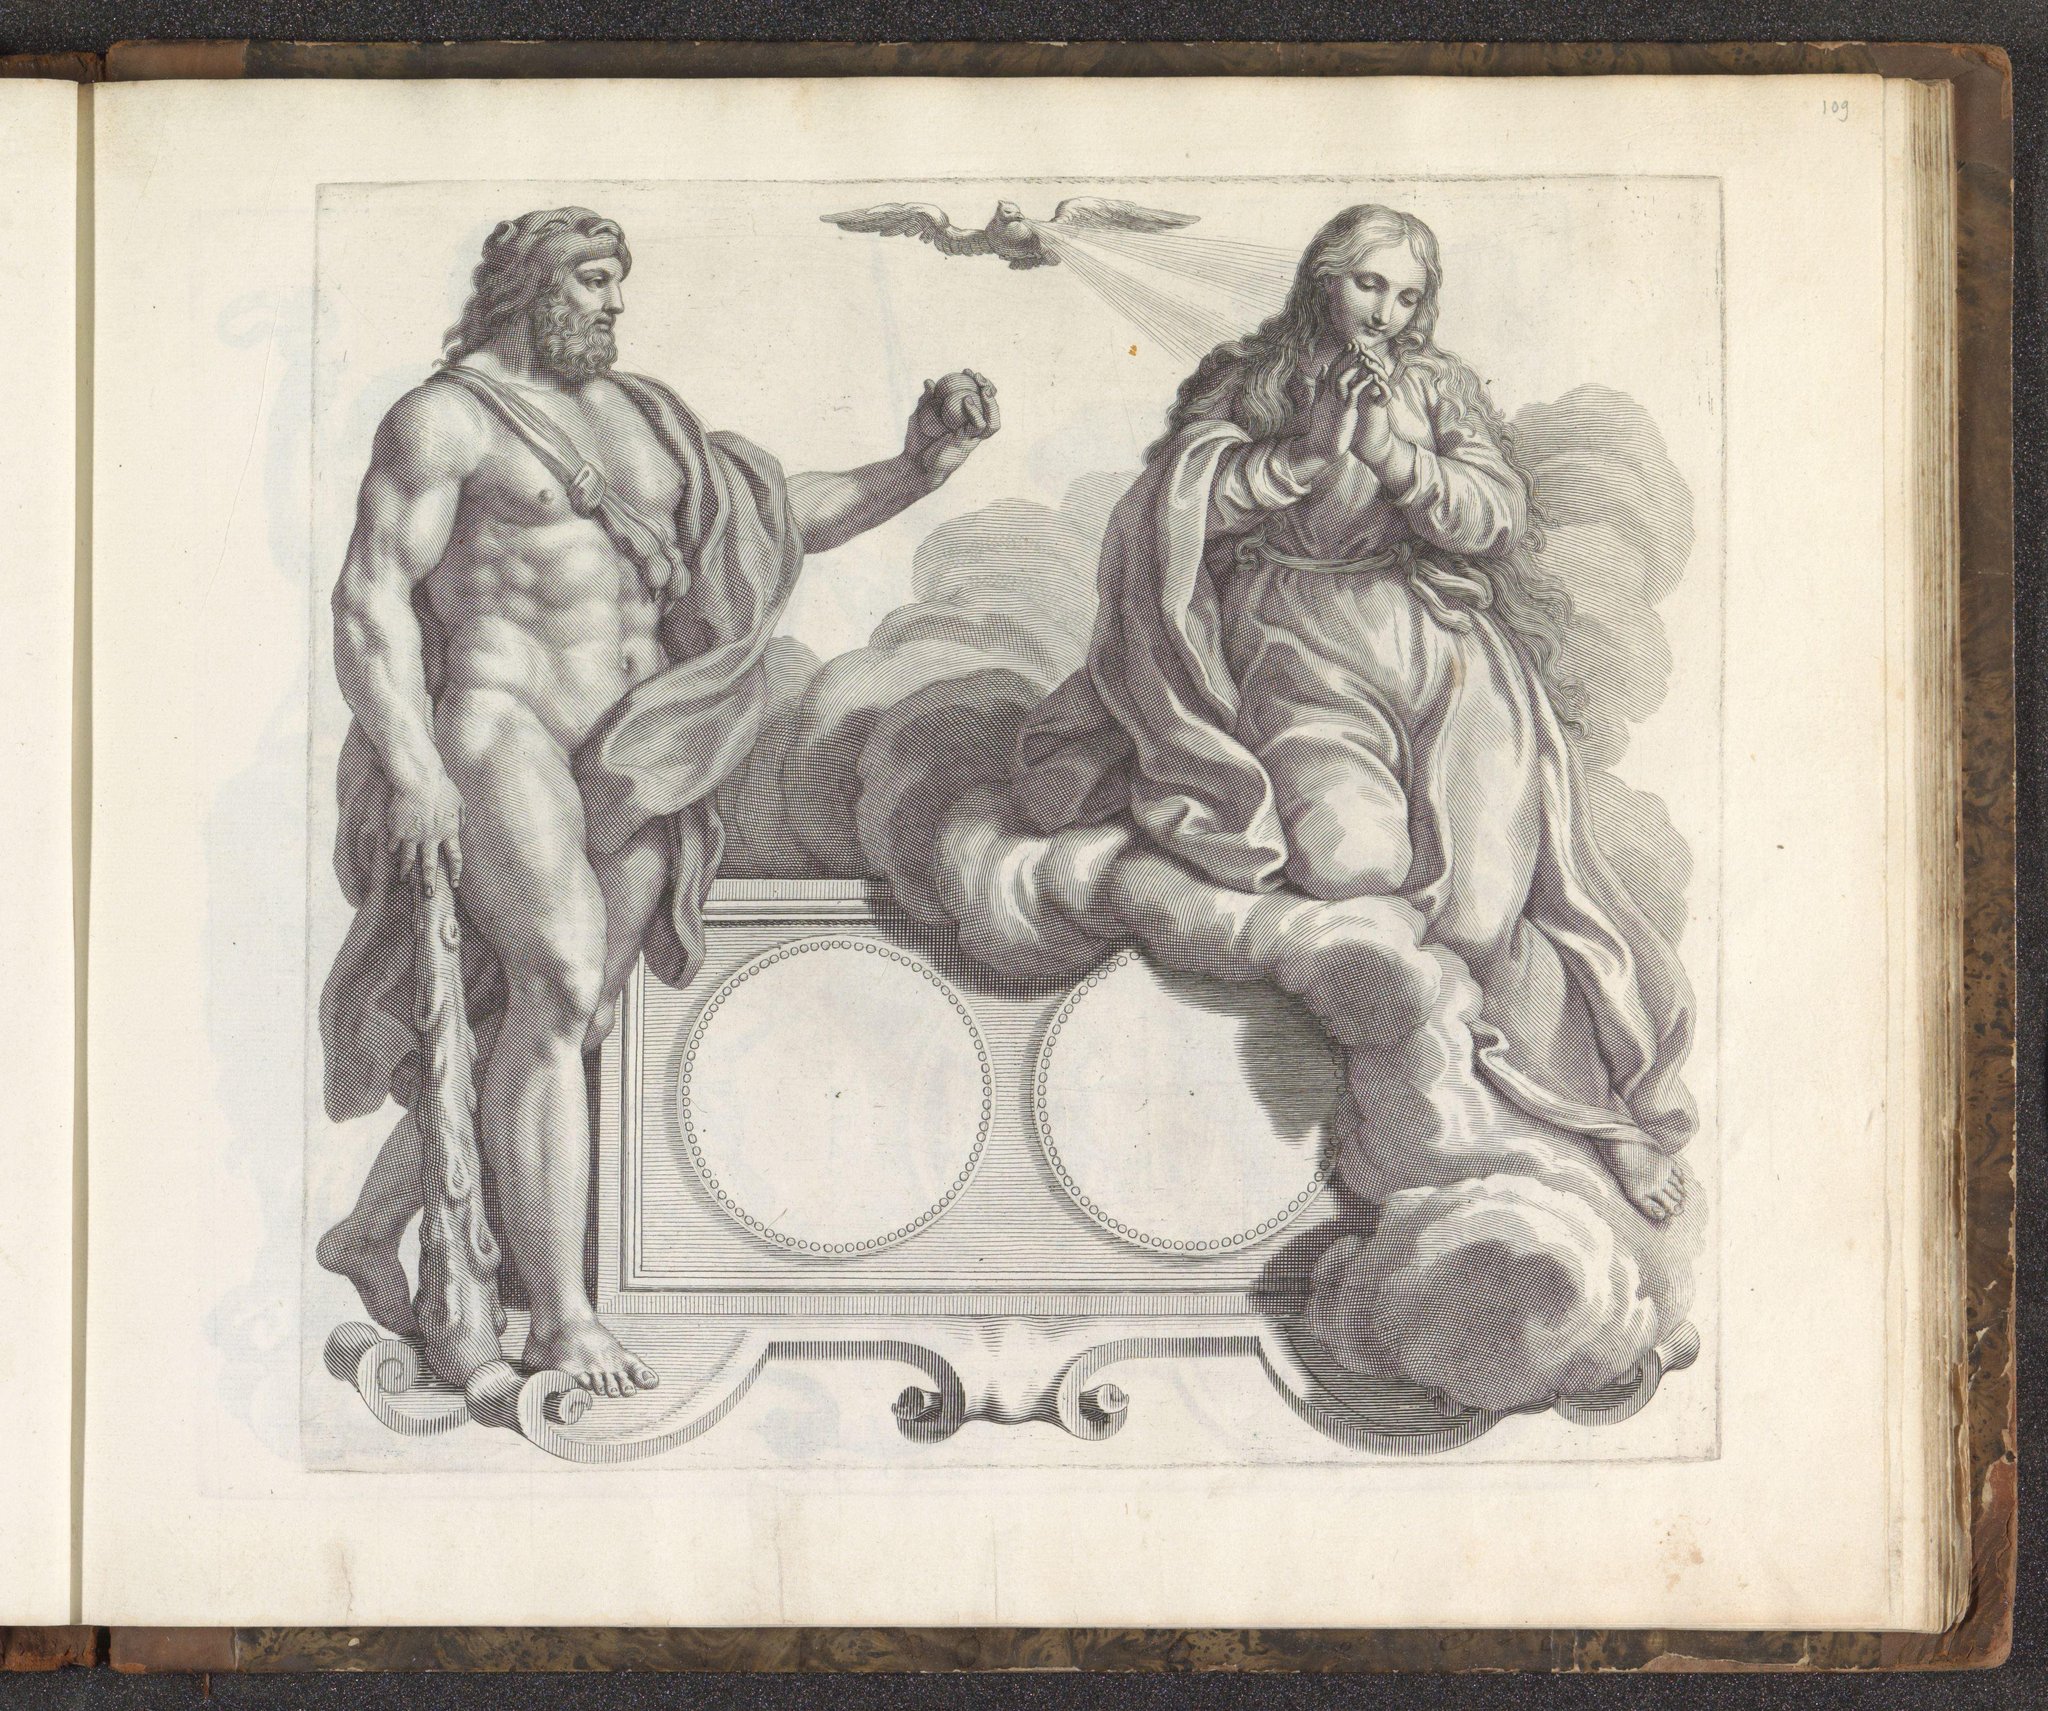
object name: album leaf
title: Numismata virorum illustrium ex Barbadica gente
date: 1673-1743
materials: paper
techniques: engraving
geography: rome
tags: (story of) hercules (heracles), symbols, allegories of peace, 'pax'; 'pace' (ripa), the golden apples of the hesperides, hercules as personification of virtue, holy ghost represented as a dove (in flames)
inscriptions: collector's mark: Lugt 2228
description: Voetstuk in de vorm van een cartouche. Daarop twee blanco medaillons. Links van het voetstuk staat Hercules. Hij heeft zijn knots in zijn rechterhand en de appels van de Hesperiden in zijn linkerhand. Hercules is de personificatie van de Dapperheid. De appelen staan volgens Ripa voor de drie heraldische deugden van Hercules. Rechts een vrome vrouw, mogelijk de personificatie van Heiligheid. Zij heeft haar handen gevouwen en lange haren die over haar schouders vallen. Boven haar een duif uit wiens bek een straal schiet. De prent maakt deel uit van een album.